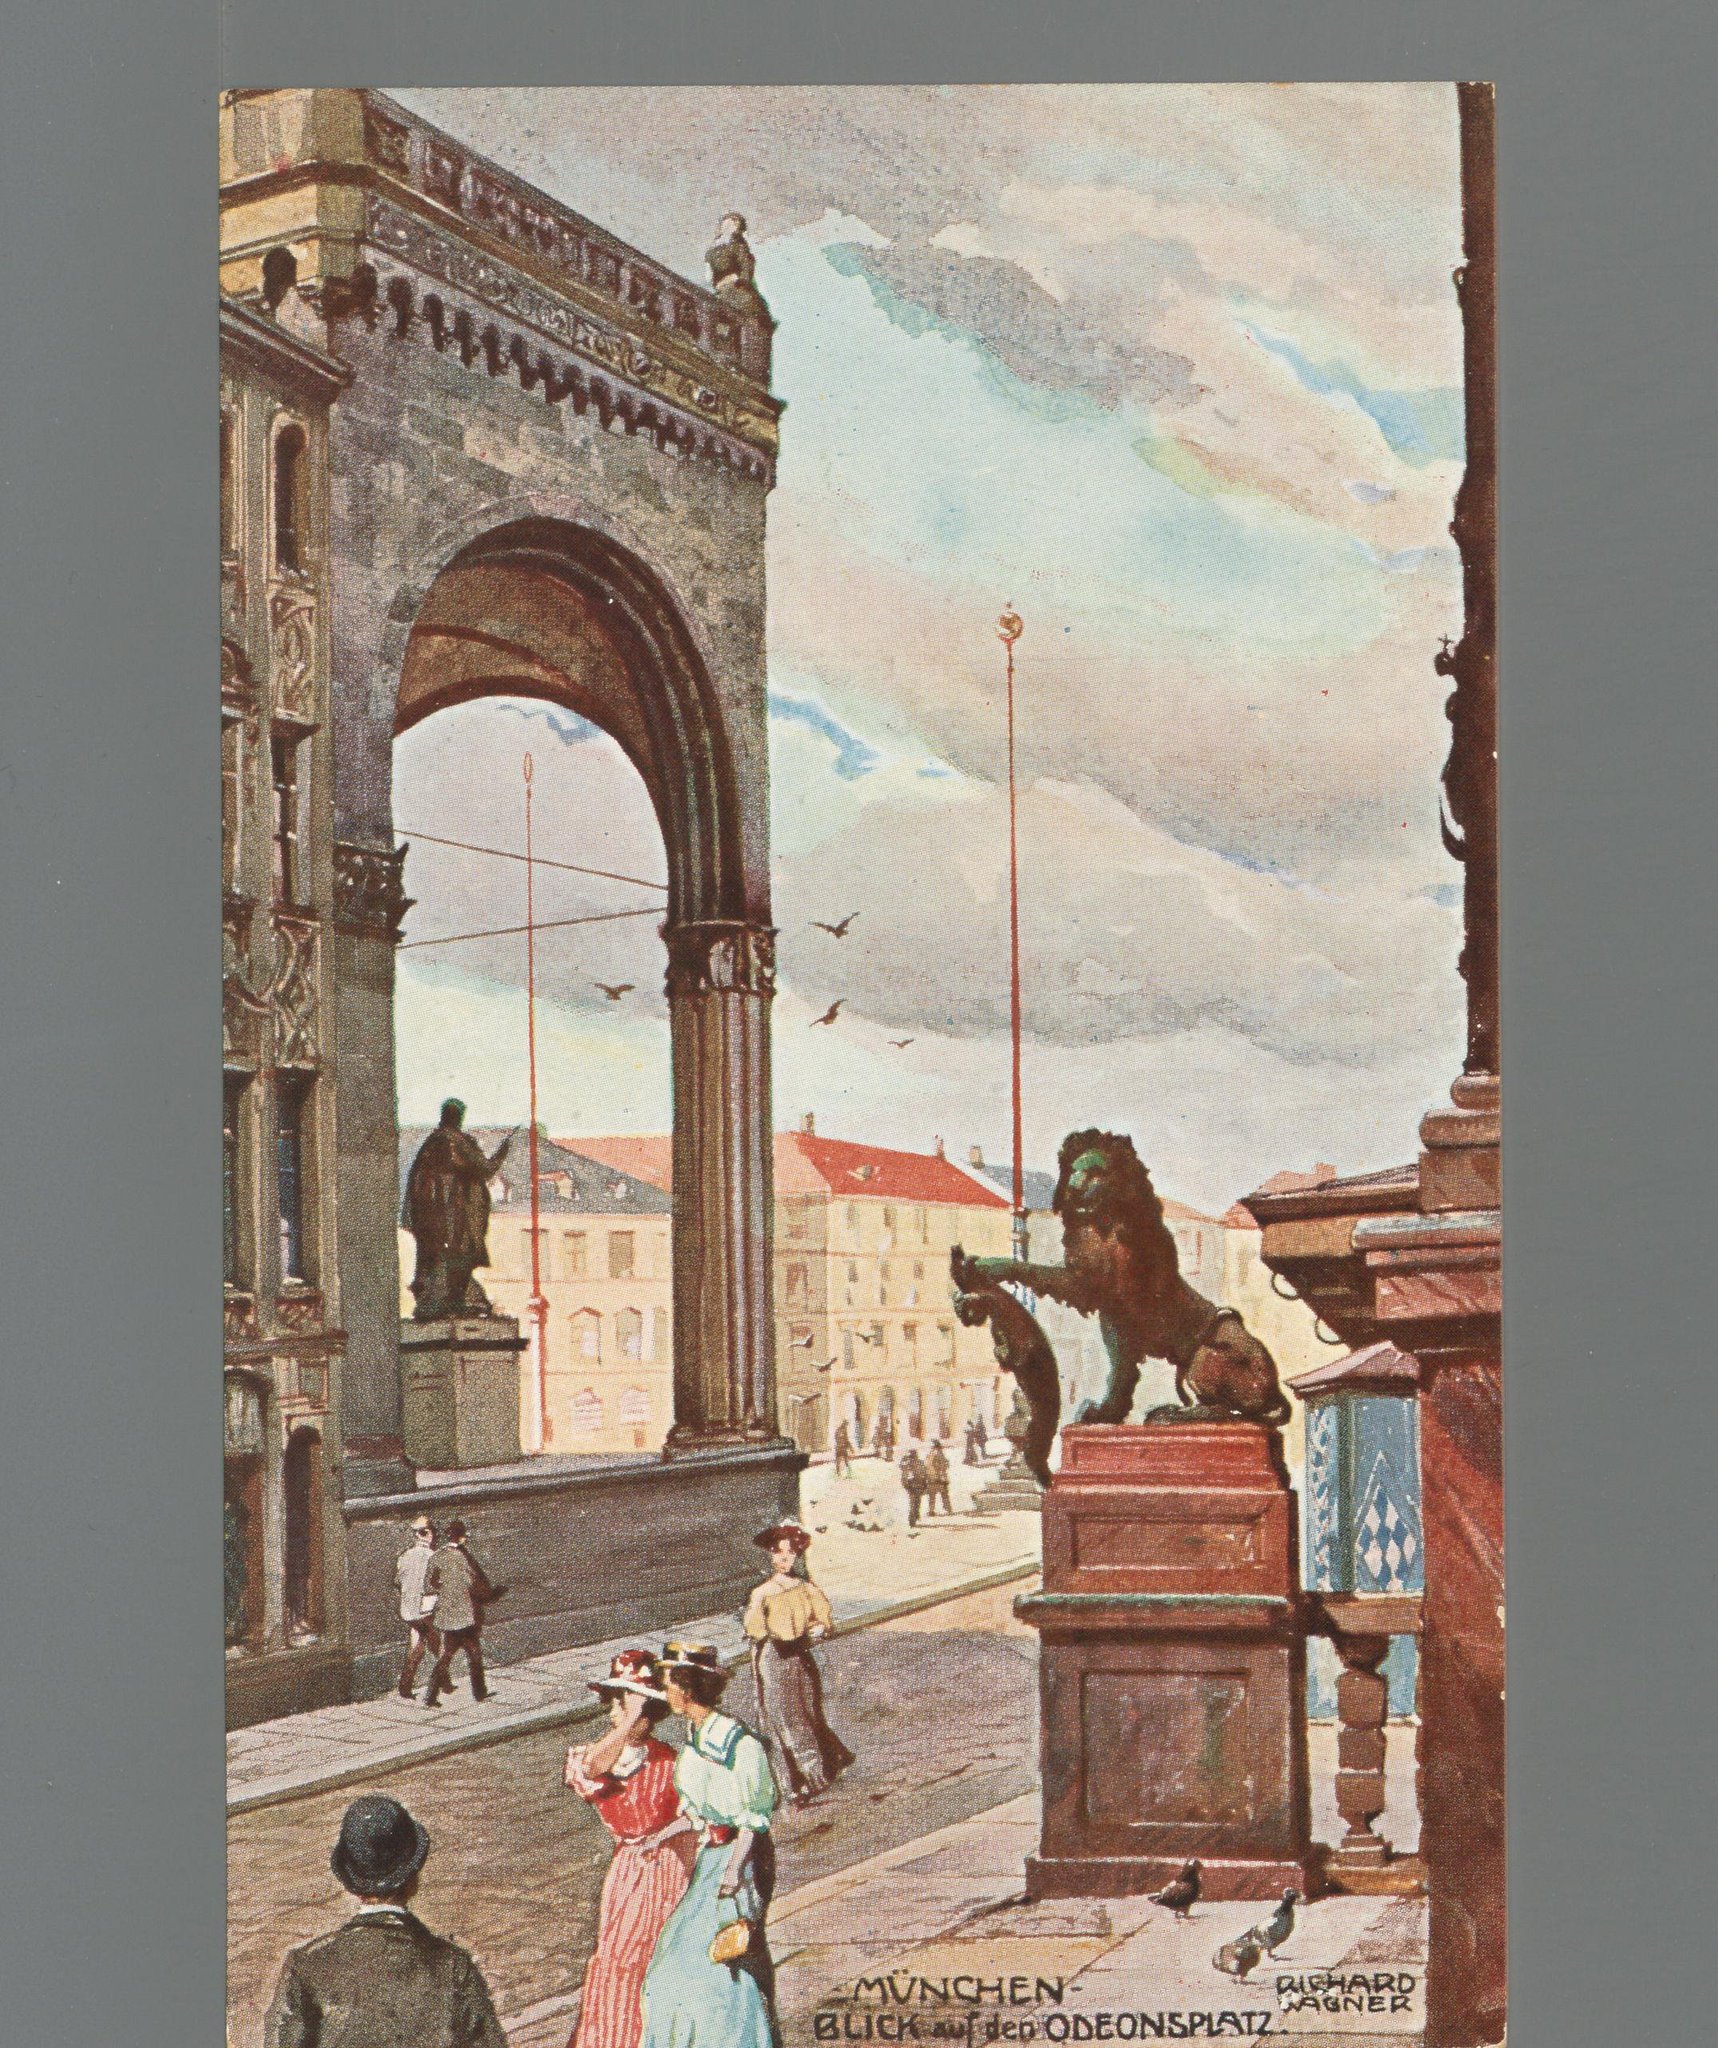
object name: ansichtkaart, prentbriefkaart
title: Aquarell-Serie München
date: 1905-1930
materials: cardboard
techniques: color autotype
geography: munich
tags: square, place, circus, etc., monument, statue